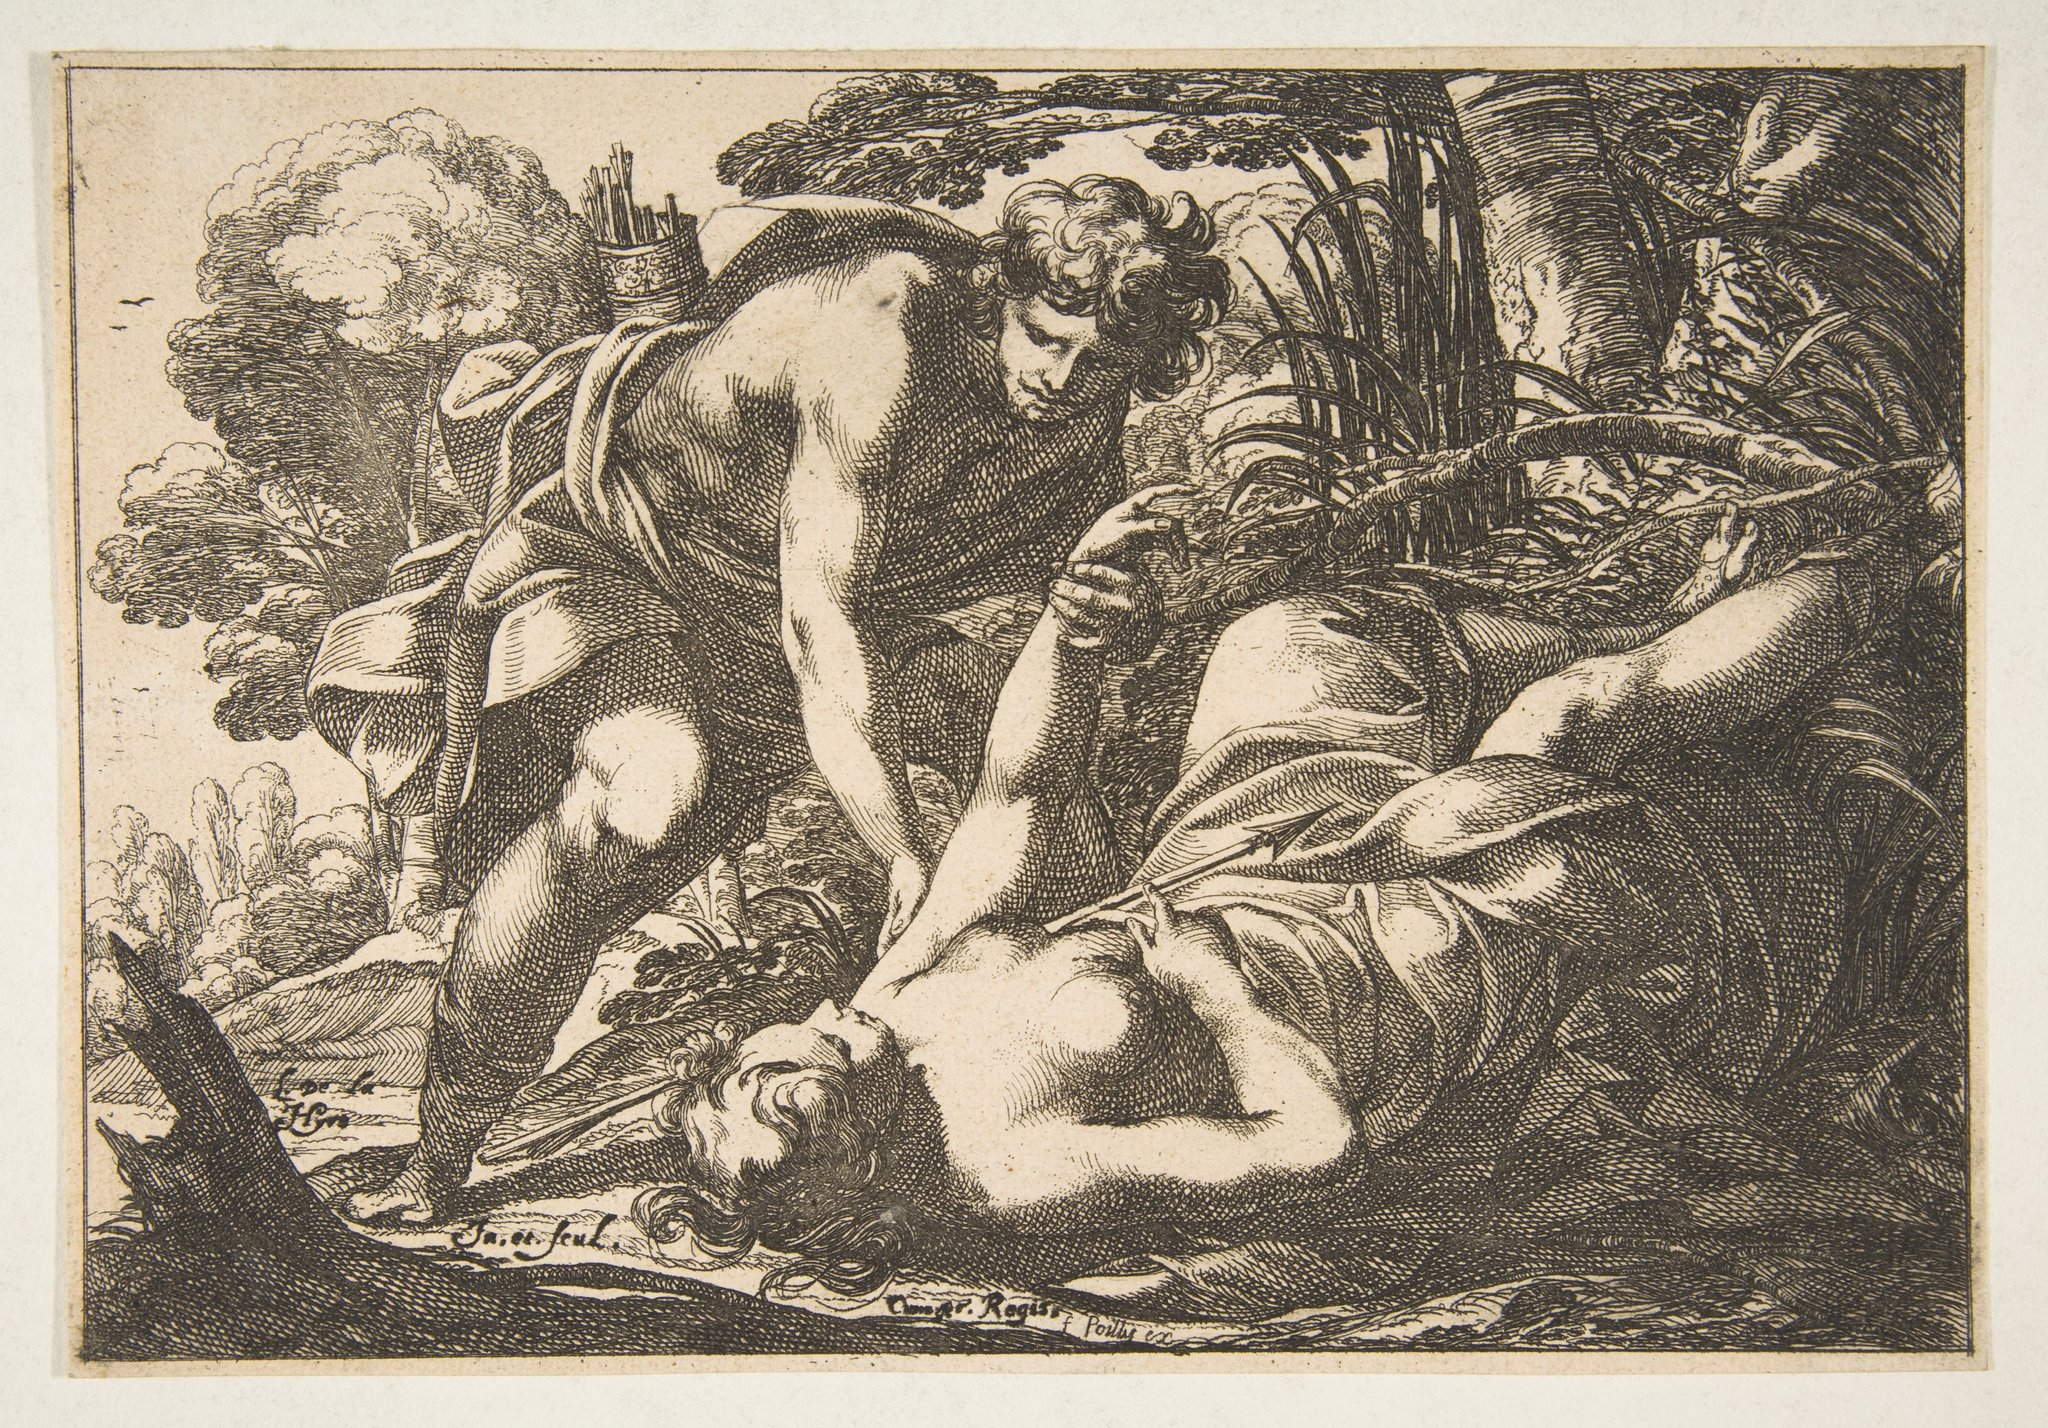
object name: print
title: Apollo and Clytie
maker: laurent de la hyre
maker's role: artist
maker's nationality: french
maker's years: 1606-1656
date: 1606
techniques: etching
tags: arrows,female nudes,apollo